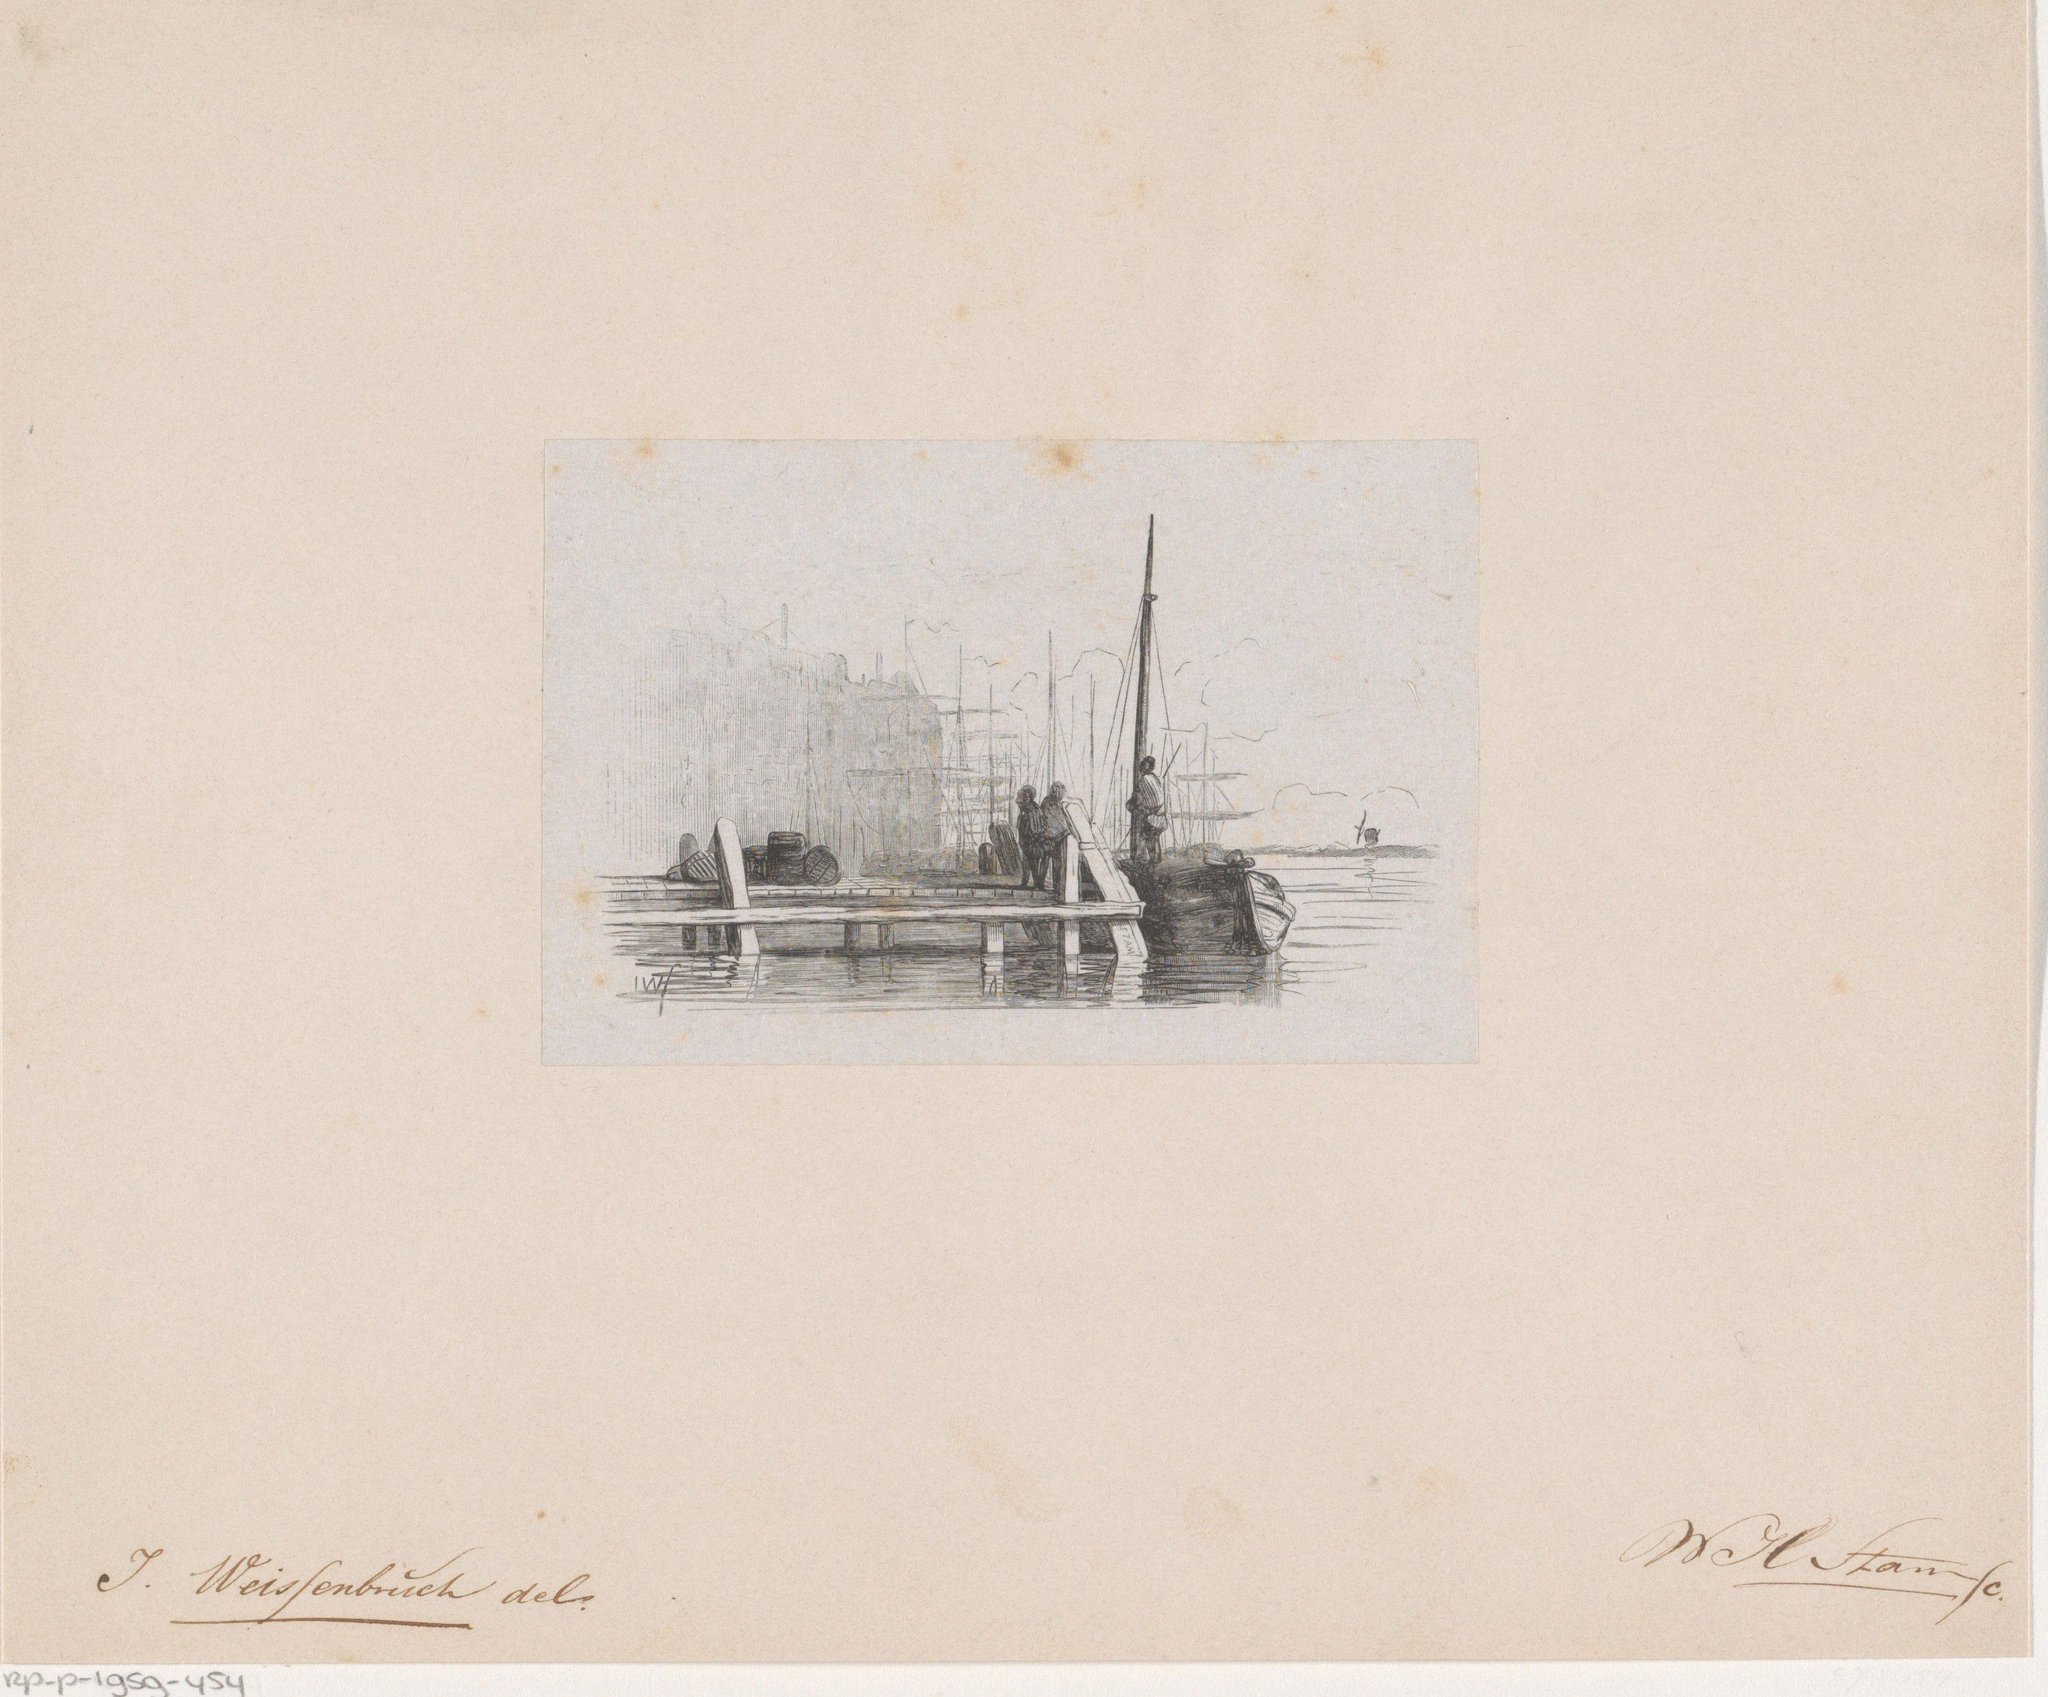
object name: print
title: Aanlegsteiger met figuren bij een boot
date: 1841-1874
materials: paper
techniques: engraving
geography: the hague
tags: sailing-ship, sailing-boat, pier, quay, wharf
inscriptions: collector's mark: Lugt 2228